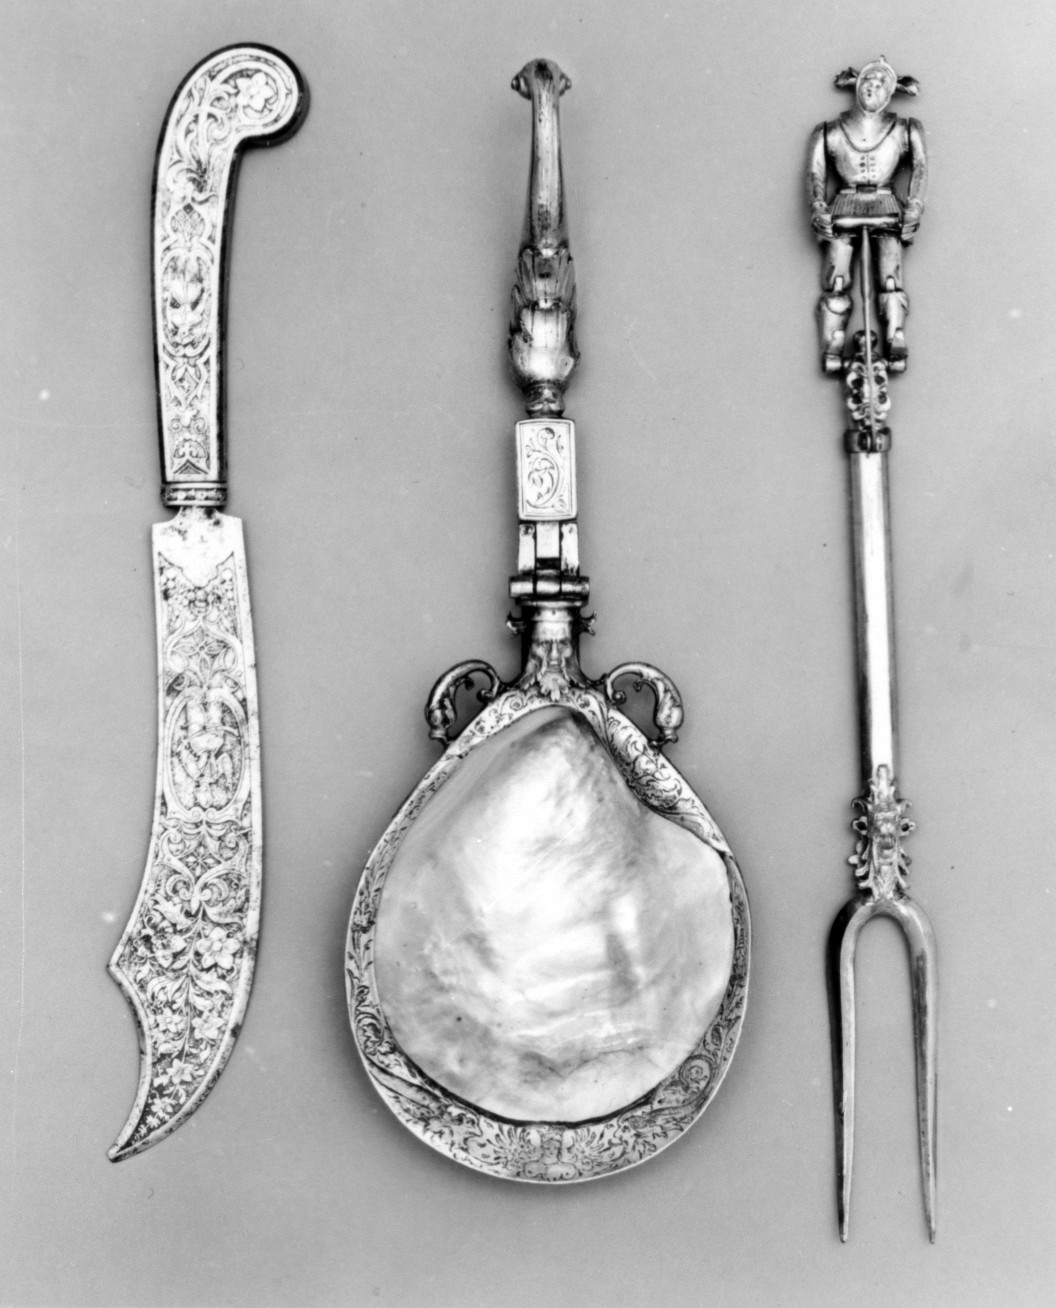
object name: fork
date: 1801-1900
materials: brass, gilt, steel